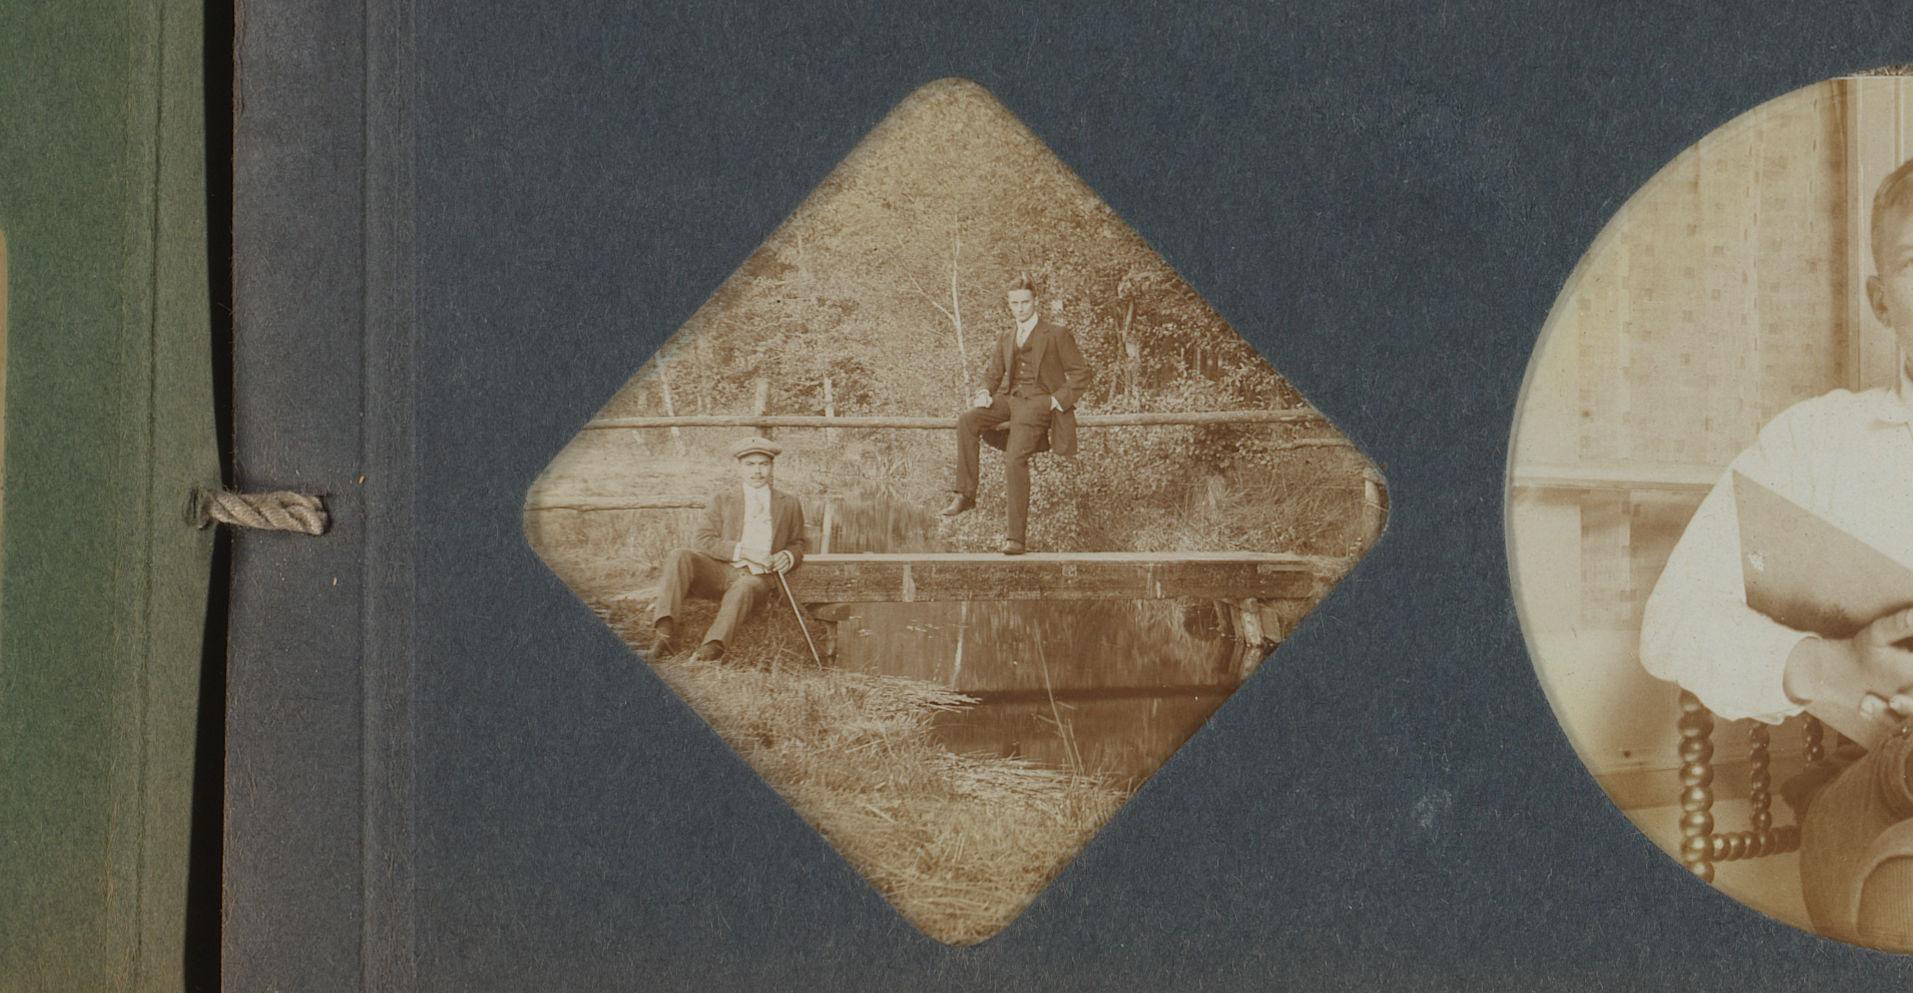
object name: album leaf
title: Jan Hellendoorn en een jonge man, aangeduid als Miel, bij een sloot, vermoedelijk in Gelderland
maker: Anonymous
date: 1912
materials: paper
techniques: gelatin silver print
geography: gelderland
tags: youth, adolescent, gelderland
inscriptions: inscription: ‘Miel en Jan Hellendoorn’